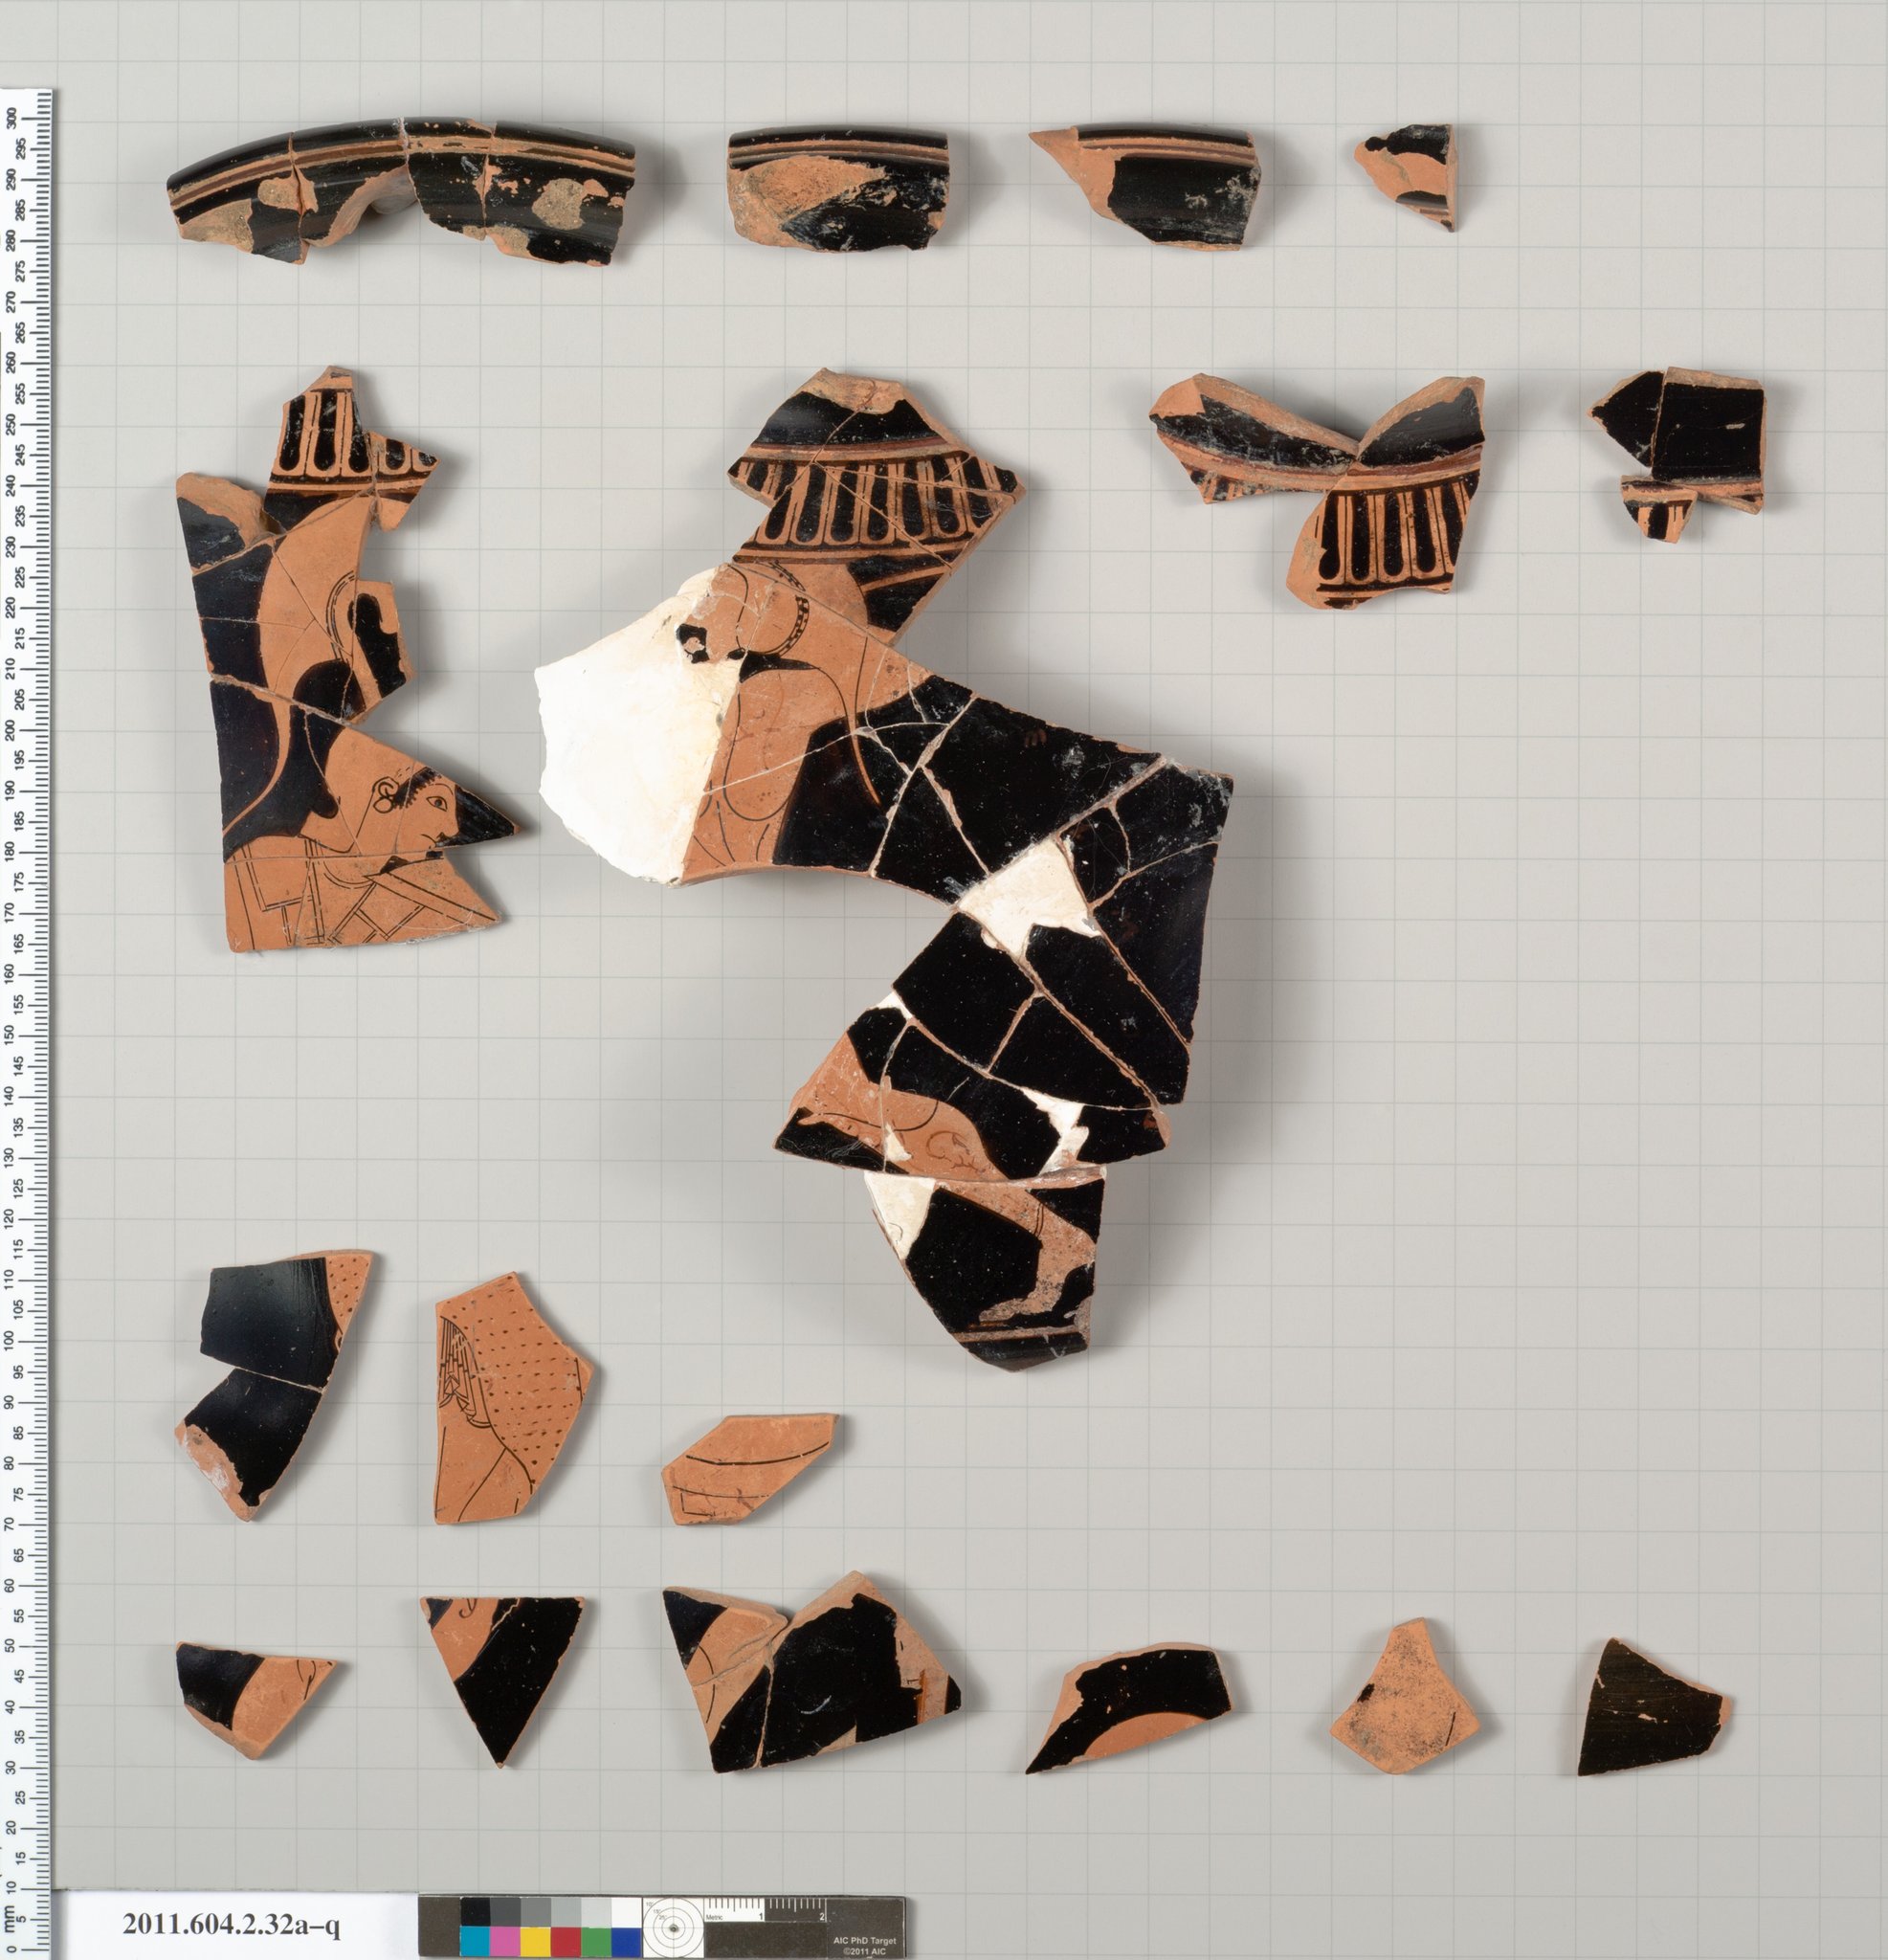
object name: psykter fragment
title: Terracotta fragments of a psykter (vase for cooling wine)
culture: greek, attic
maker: euphronios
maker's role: artist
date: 520-510 BCE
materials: terracotta